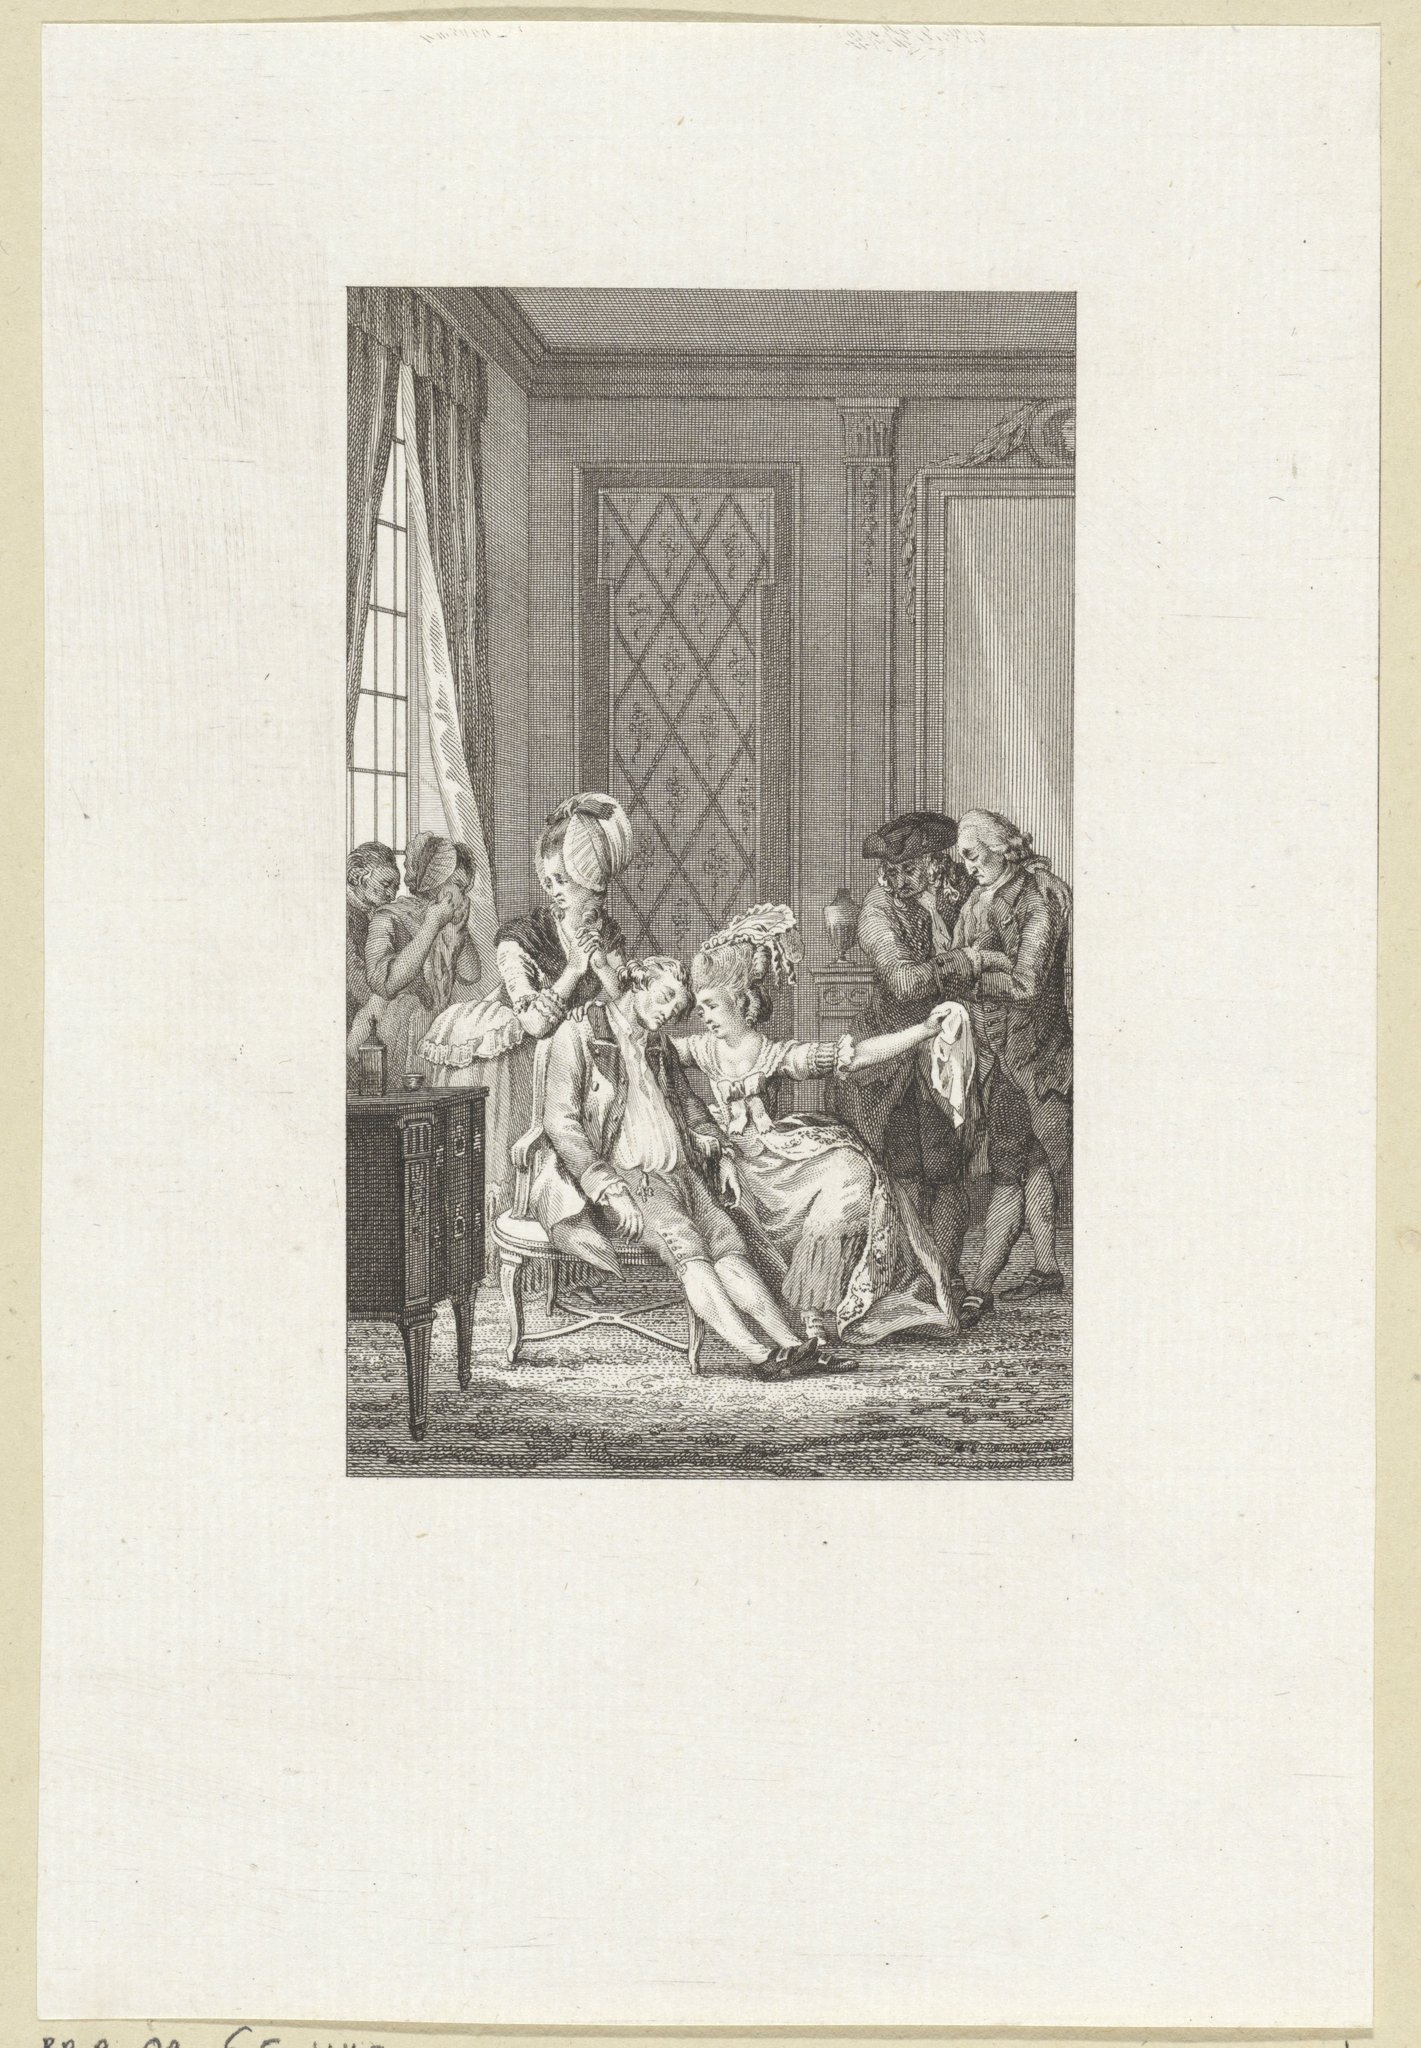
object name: print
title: Dorval sterft in de armen van een vrouw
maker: reinier vinkeles (i)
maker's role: draughtsman, print maker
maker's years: 1741-1816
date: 1781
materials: paper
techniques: engraving, etching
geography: amsterdam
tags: 'sudden death', mourning the dead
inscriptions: collector's mark: Lugt 240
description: Proefdruk van een prent die mogelijk als illustratie is gebruikt in: Sels, Willem Hendrik. Tooneelspelen voor het hart. Amsterdam: Jan Barend Elwe, 1790.